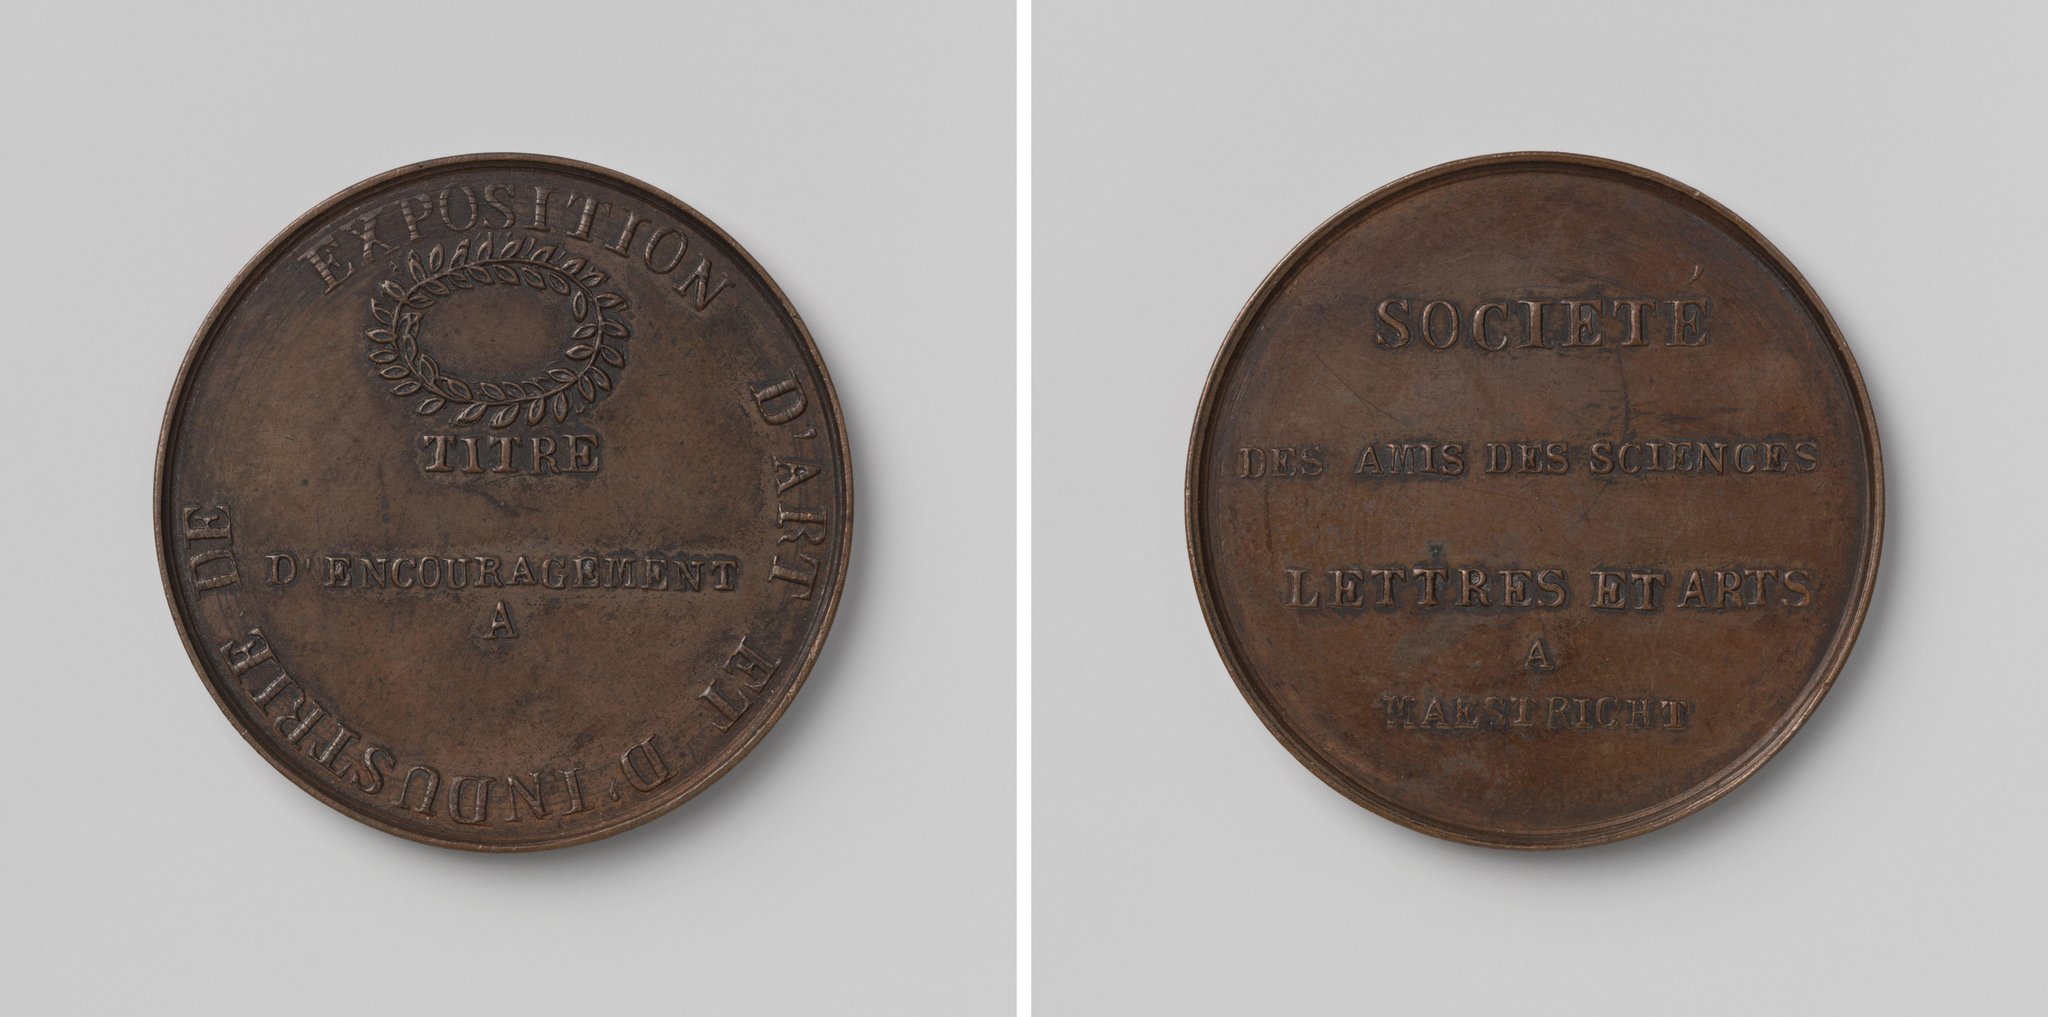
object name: medal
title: Tentoonstelling van voortbrengselen van kunst en nijverheid te Maastricht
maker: Anonymous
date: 1834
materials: bronze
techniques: striking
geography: netherlands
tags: maastricht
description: Bronzen penning. Voorzijde: lauwerkrans boven opschrift binnen omschrift. Keerzijde: opschrift